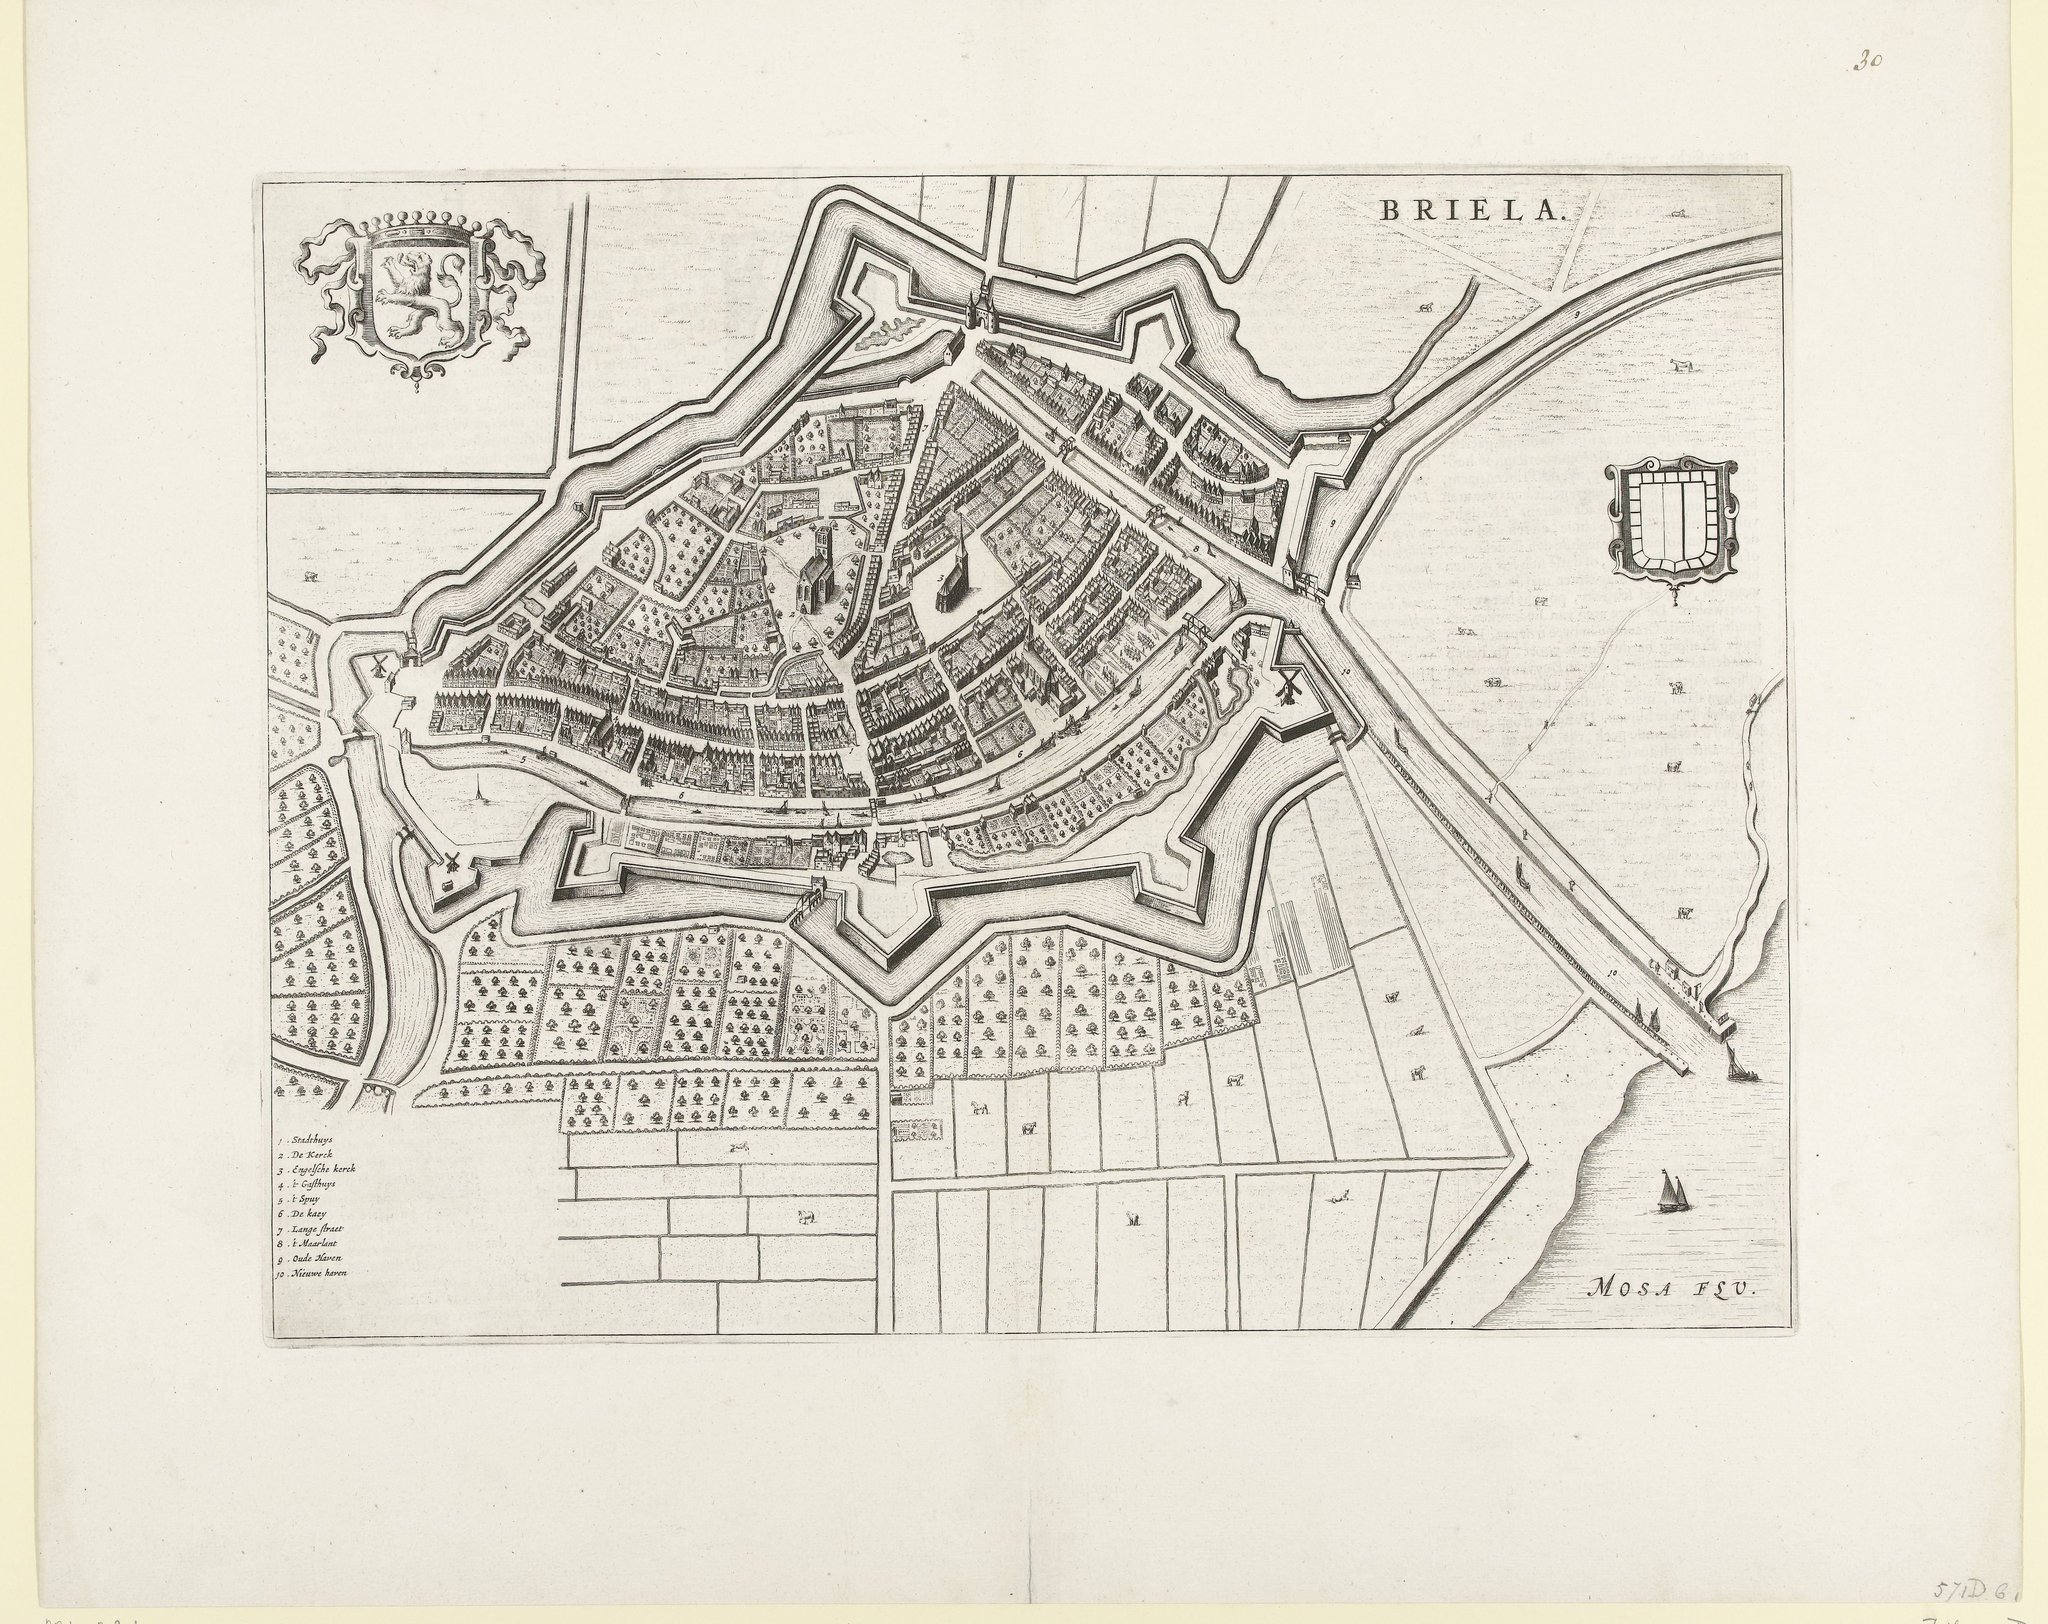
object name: map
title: Plattegrond van Den Briel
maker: Anonymous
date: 1647-1649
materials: paper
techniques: etching, letterpress printing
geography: northern netherlands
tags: maps of cities, brielle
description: Plattegrond van Den Briel en een deel van het omringend land. Linksboven het wapen van de stad, linksonder de legenda 1-10 in het Nederlands. Op een dubbelblad uit het het Stedenboek van Blaeu genomen, op beide zijden bedrukt met tekst in het Nederlands.